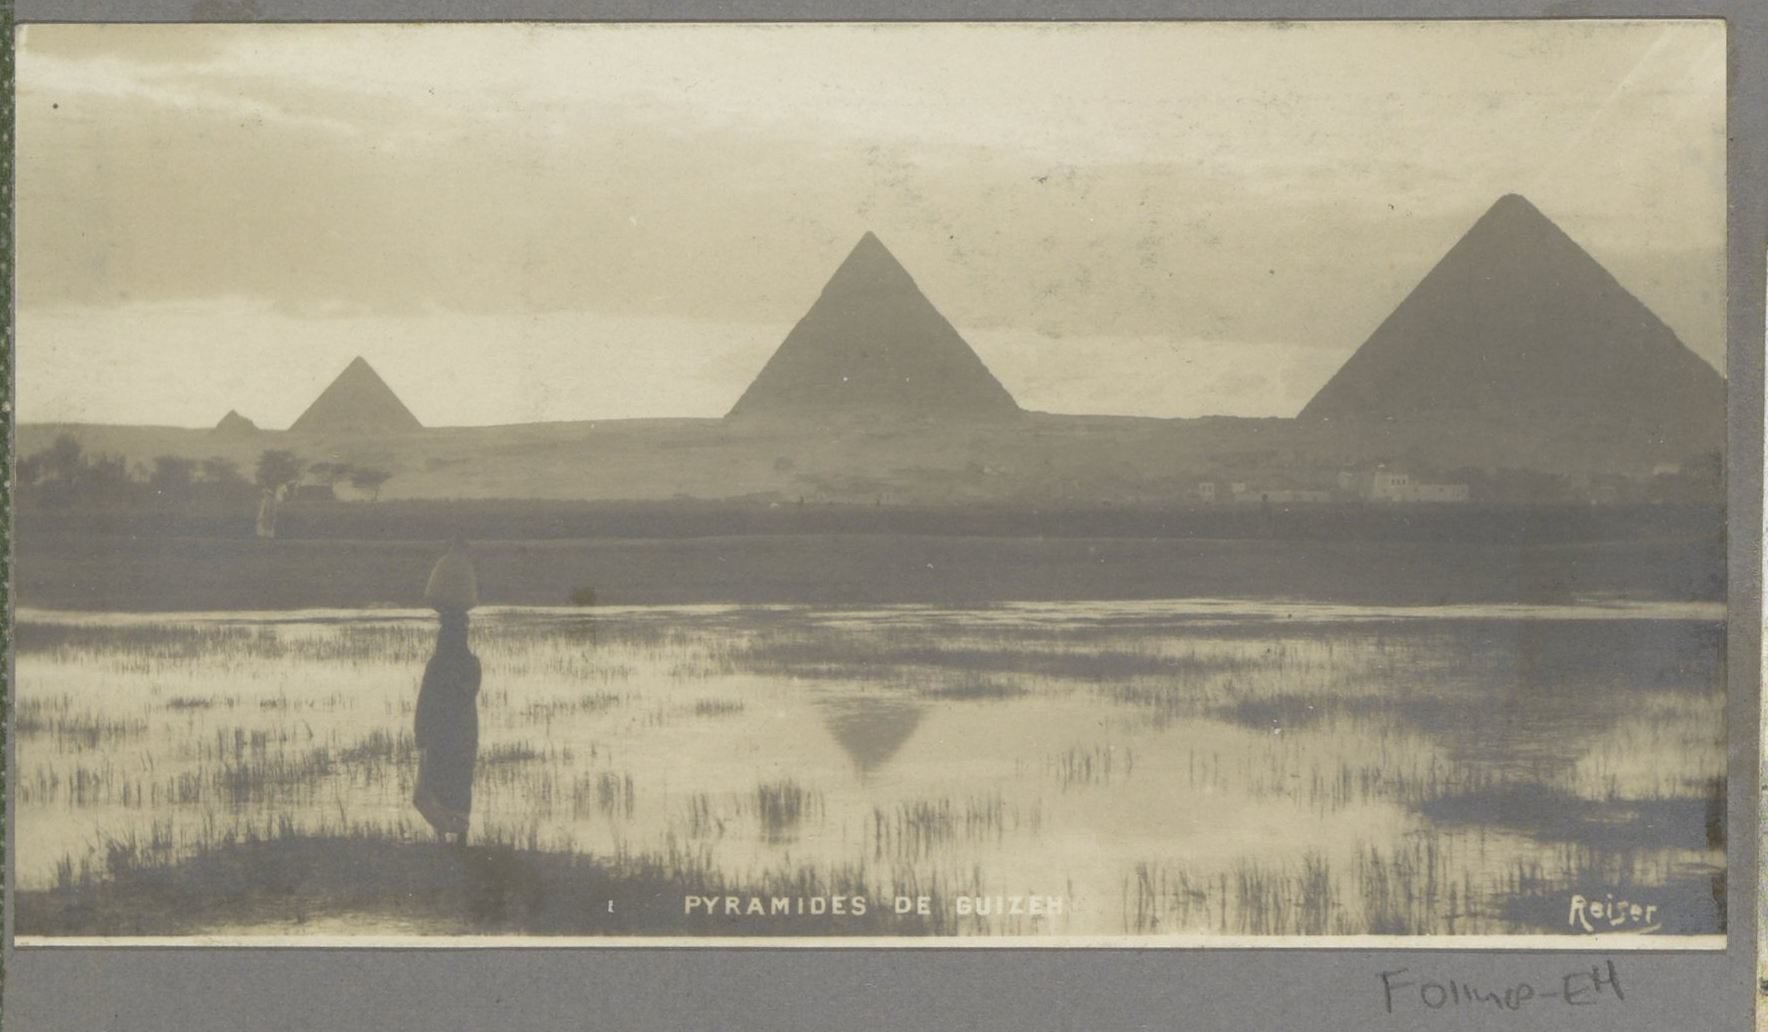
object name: photograph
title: Gezicht op de piramides van Gizeh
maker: andreas daniel reiser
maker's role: fotograaf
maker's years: 1840-1898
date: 1895-1905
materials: paper, photographic support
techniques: gelatin silver print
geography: gizeh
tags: pyramid (historical grave form)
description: Onderdeel van Reisalbum met foto's van bezienswaardigheden in Griekenland en Egypte.